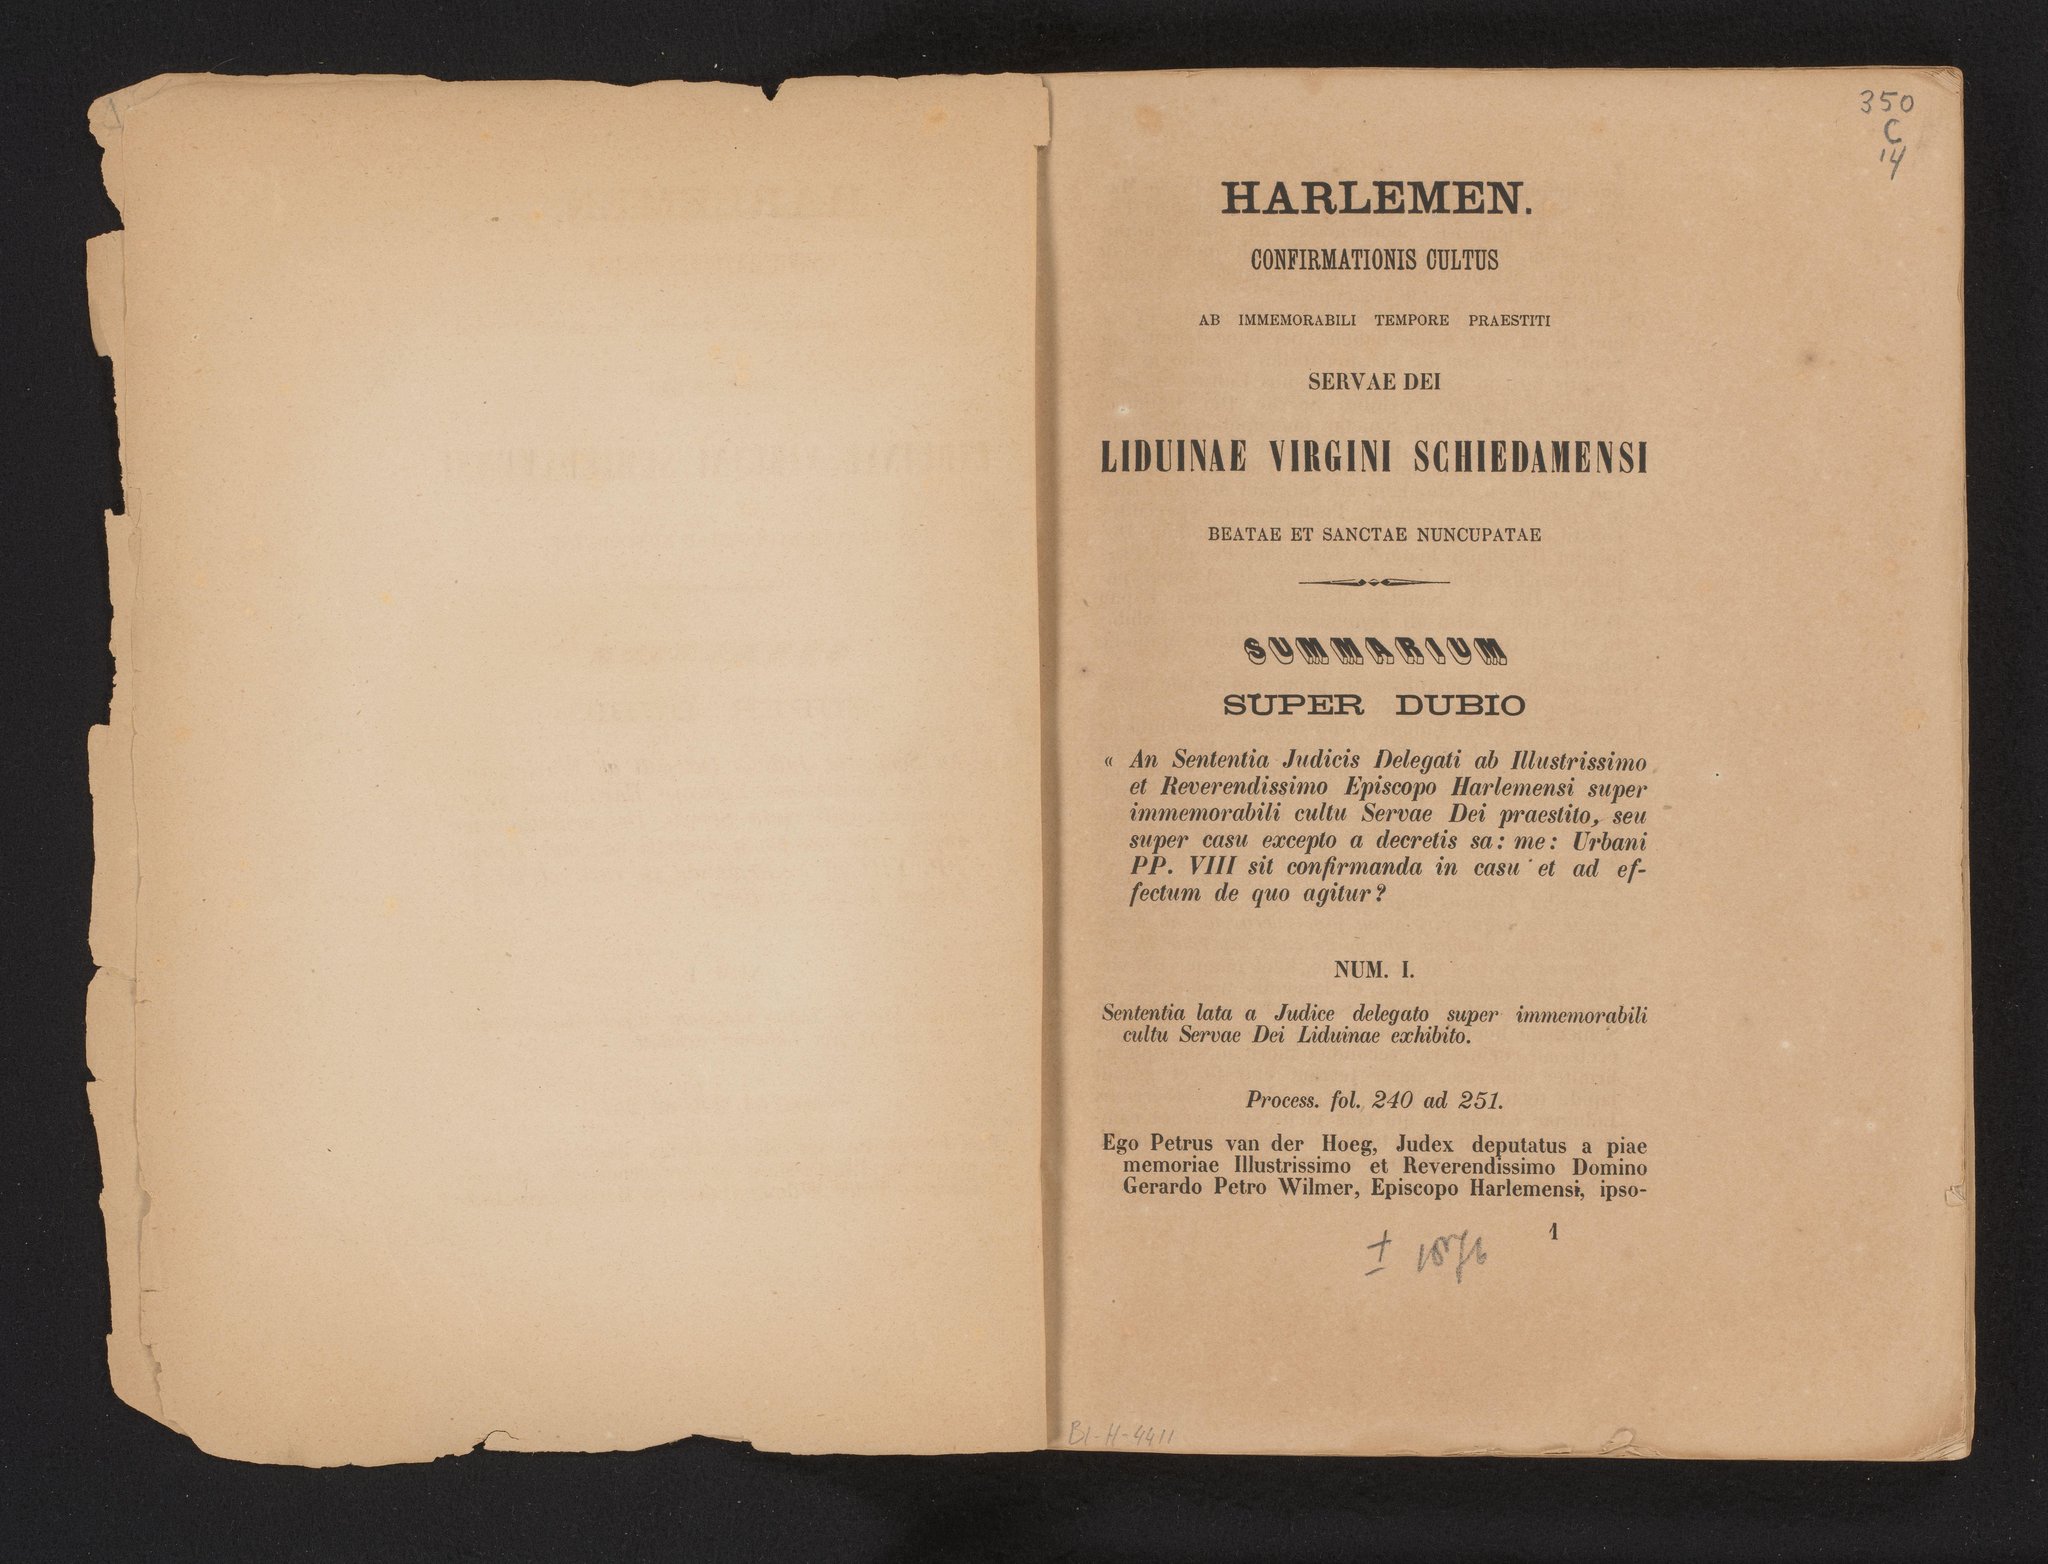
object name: book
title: Confirmationis cultus ab immemorabili tempore praestiti servae dei Liduinae Virgini Schiedamensi beatae et sanctae nuncupatae : summarium super dubio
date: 1861-1877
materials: cardboard, paper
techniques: albumen print, printing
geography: haarlem